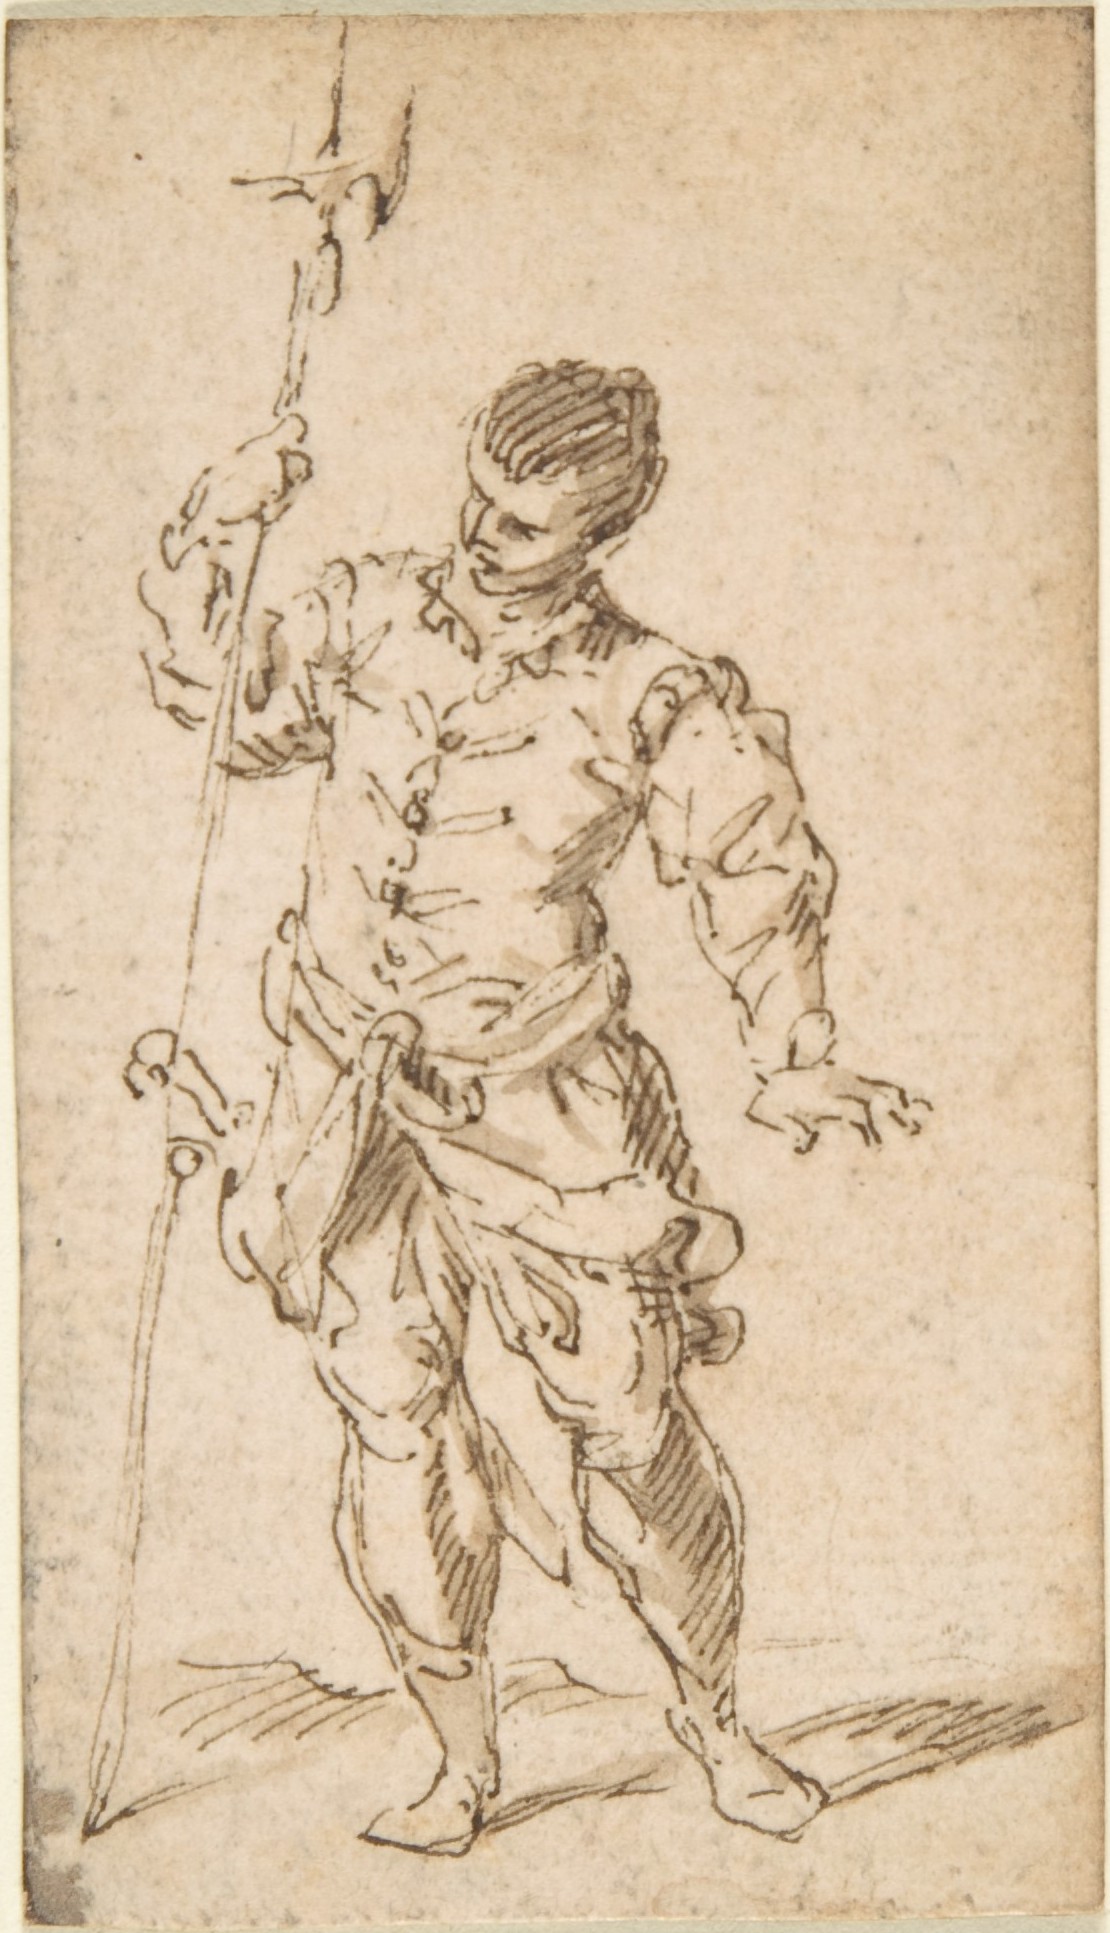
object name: drawing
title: Soldier with Halberd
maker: claude gillot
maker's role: artist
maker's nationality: french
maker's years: 1673-1722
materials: ink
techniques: brush, pen, wash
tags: soldiers,weapons